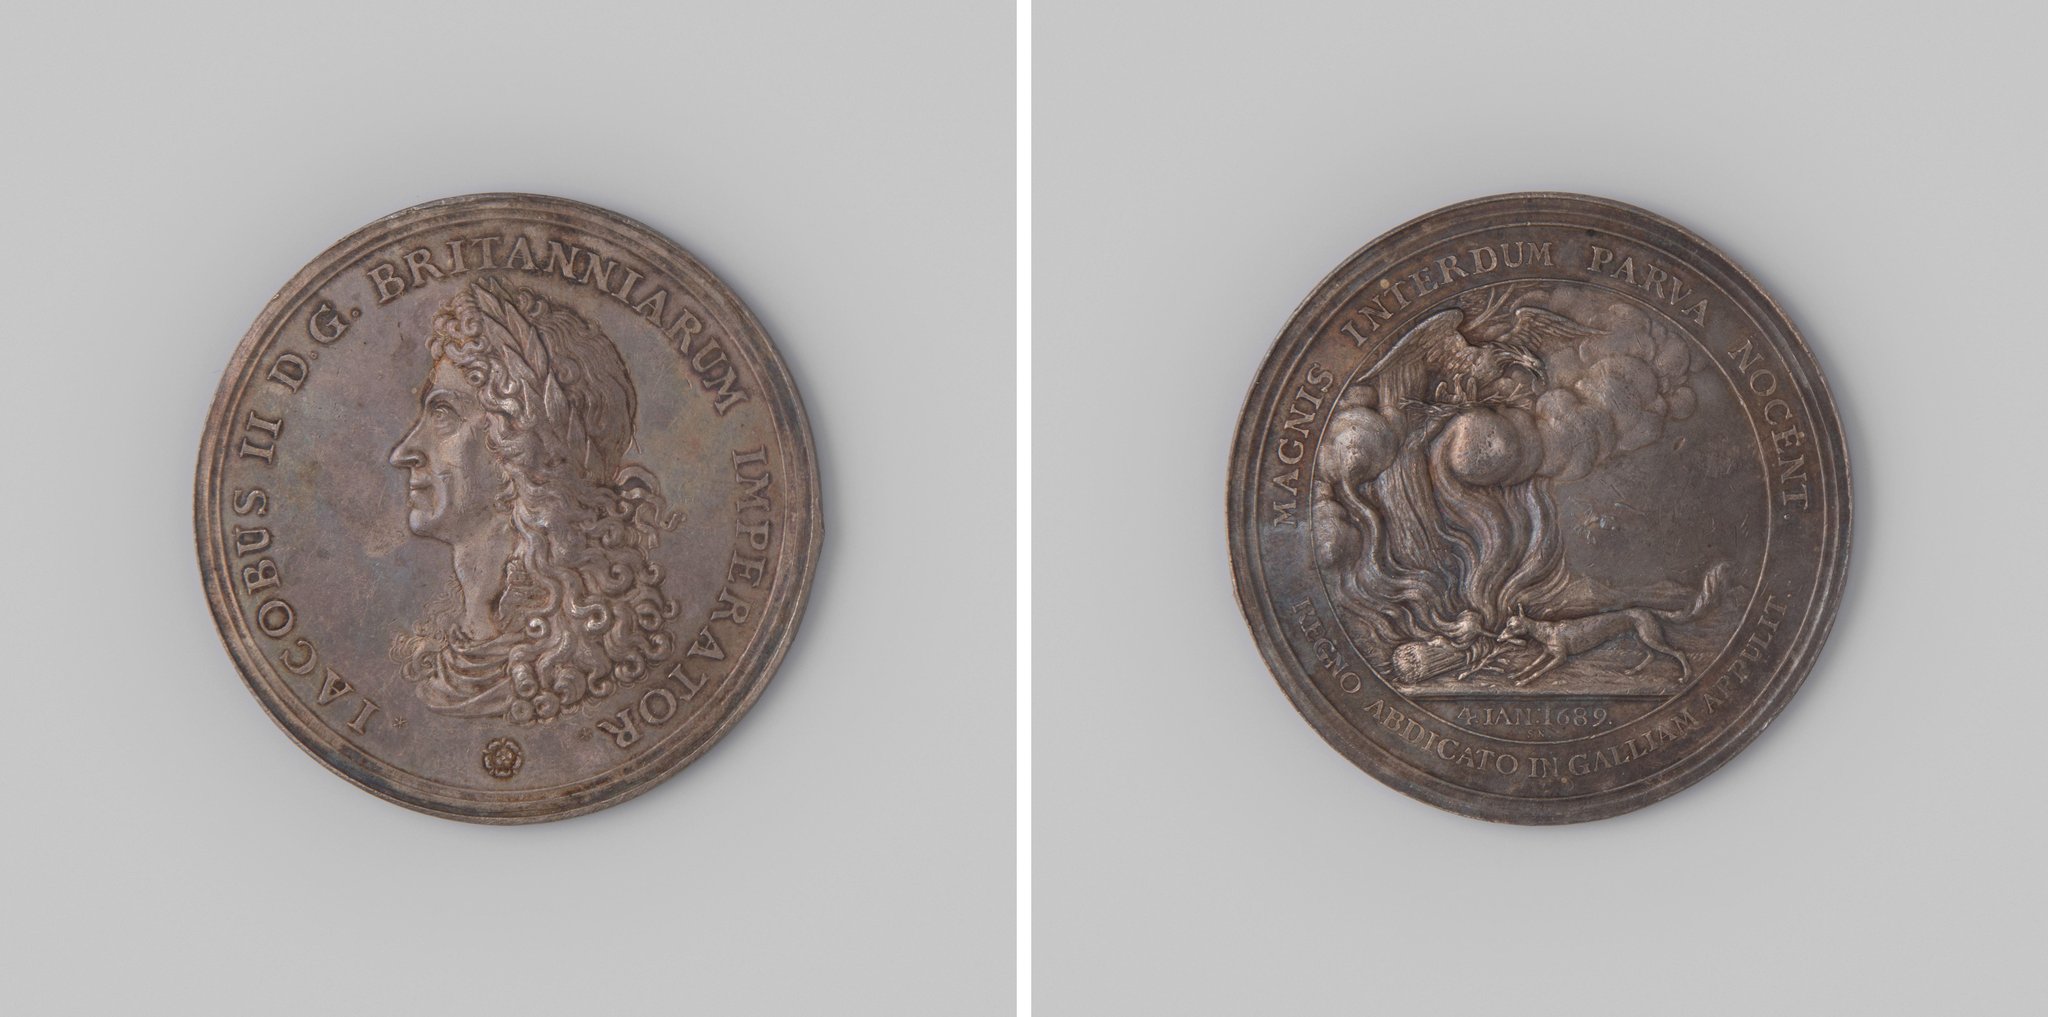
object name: history medal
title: Aankomst van Jacobus II in Frankrijk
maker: jan smeltzing (i)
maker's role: modelleur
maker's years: 1656-1693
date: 1689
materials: silver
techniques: striking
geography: leiden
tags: jacobus ii (koning van engeland en schotland), france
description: Zilveren penning. Voorzijde: borststuk man met lauwerkrans binnen omschrift. Keerzijde: vos die arendsnest in brand steekt boven opschrift, binnen omschrift